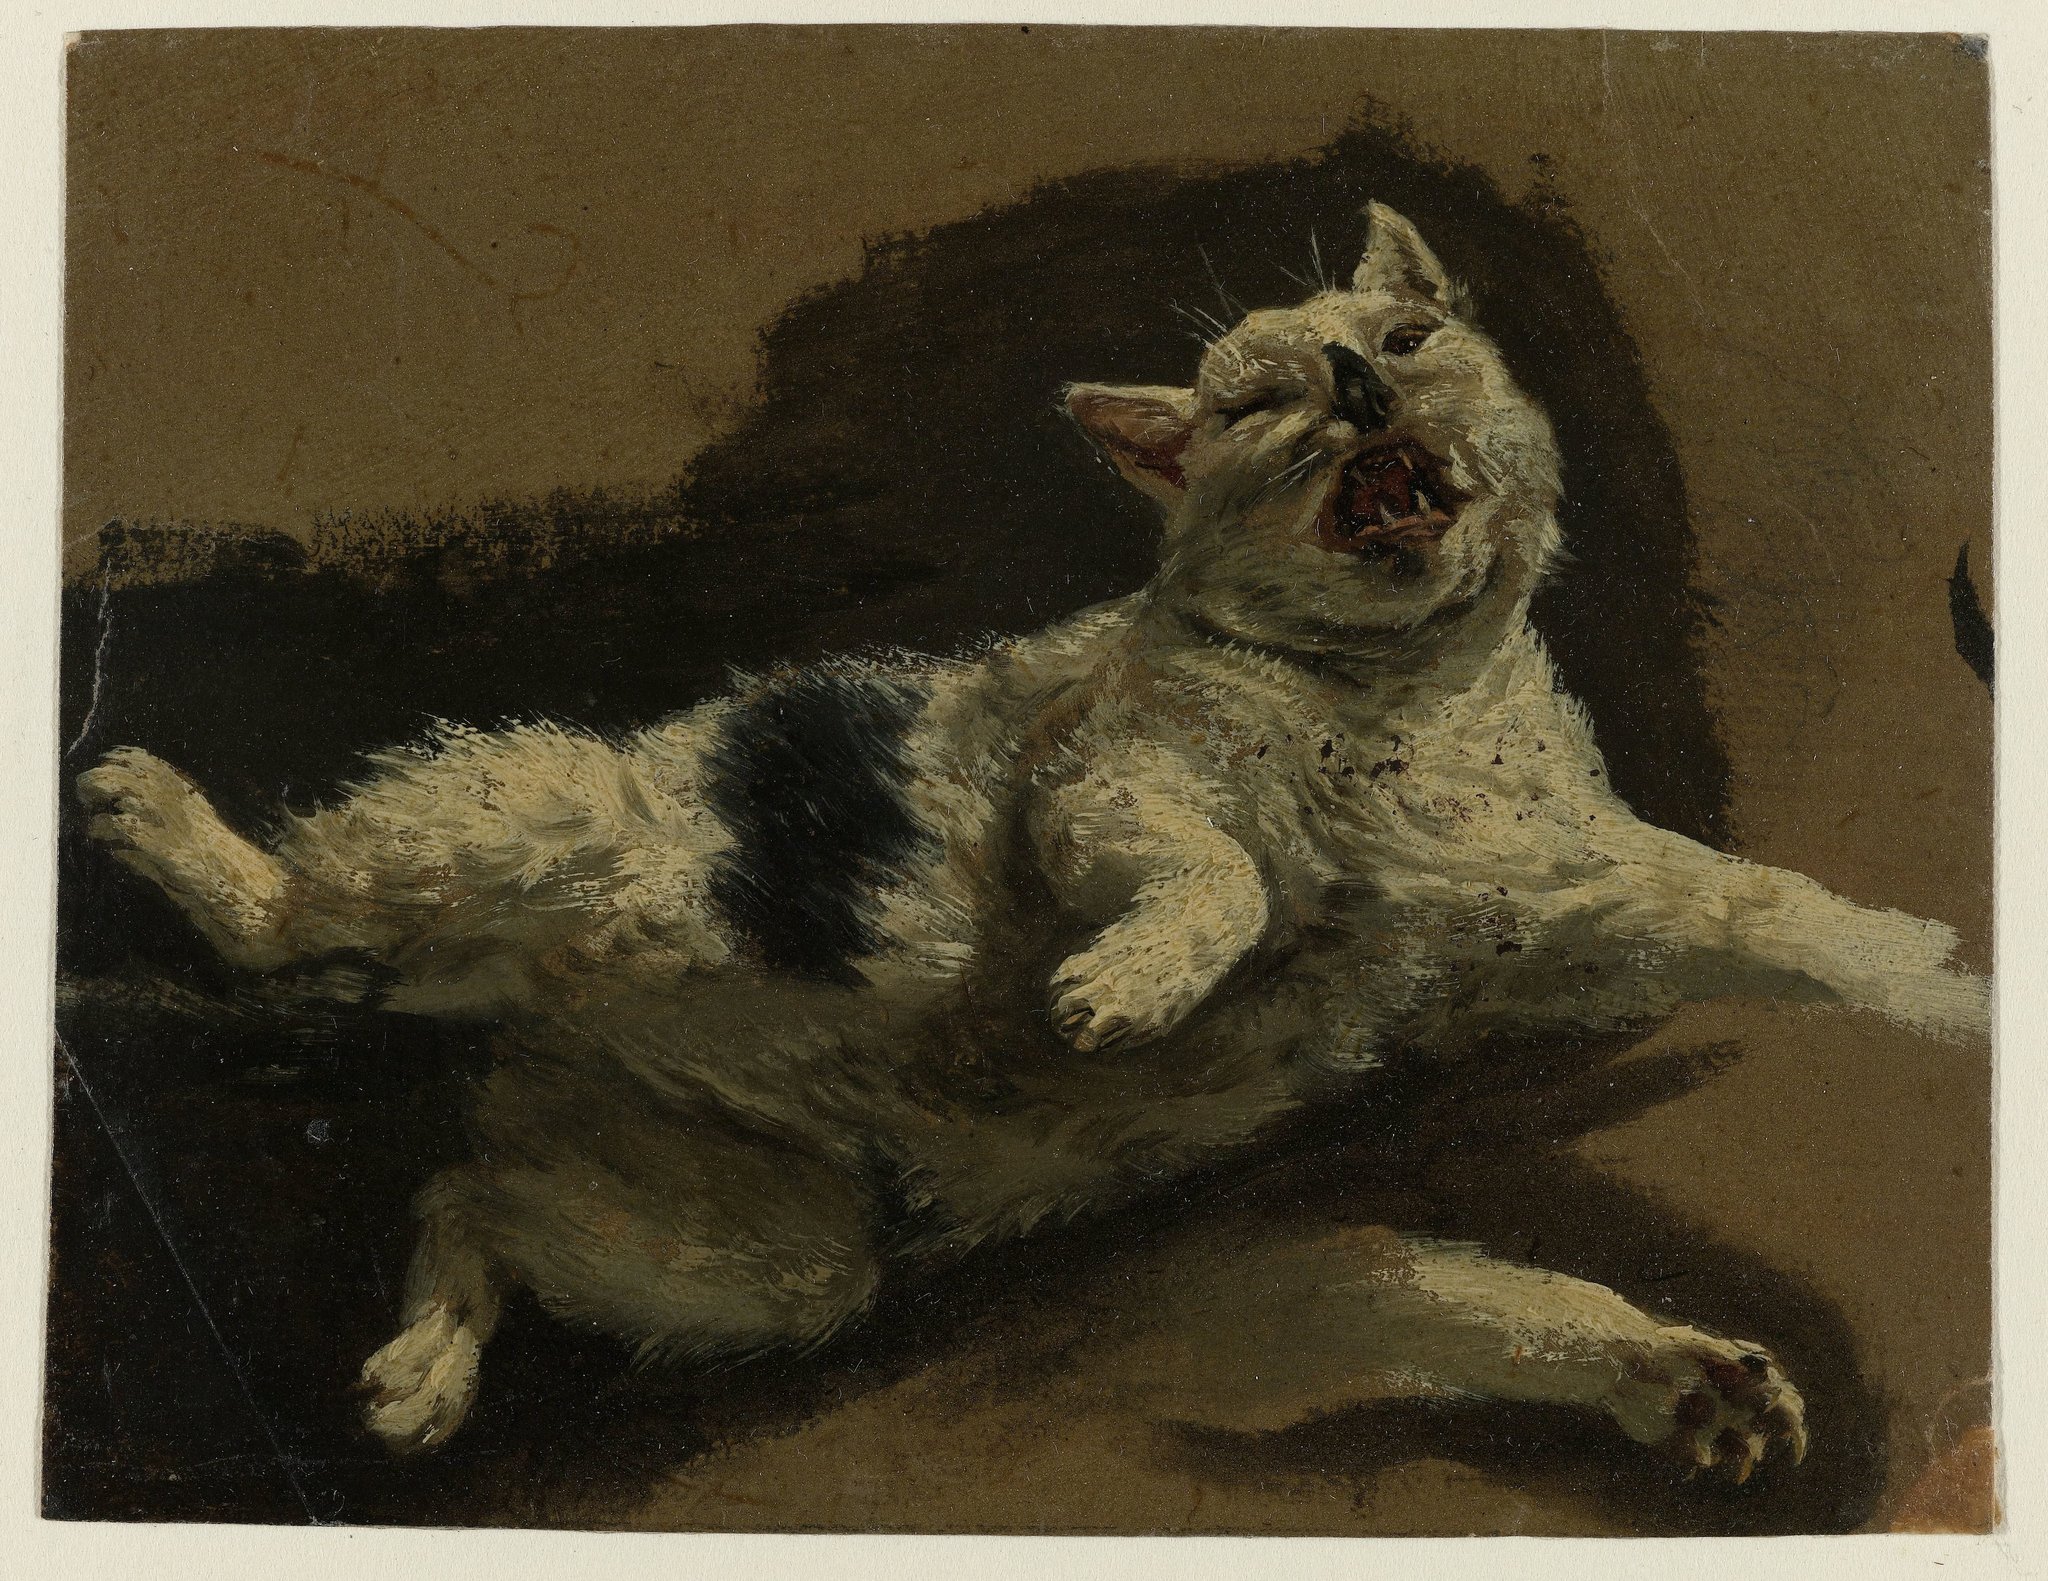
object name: drawing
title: Kat liggend op de rug en los pootje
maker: adriaen van de velde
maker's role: draughtsman, painter, print maker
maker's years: 1636-1672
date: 1646-1672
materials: oil, paper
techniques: brush, varnishing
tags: cat